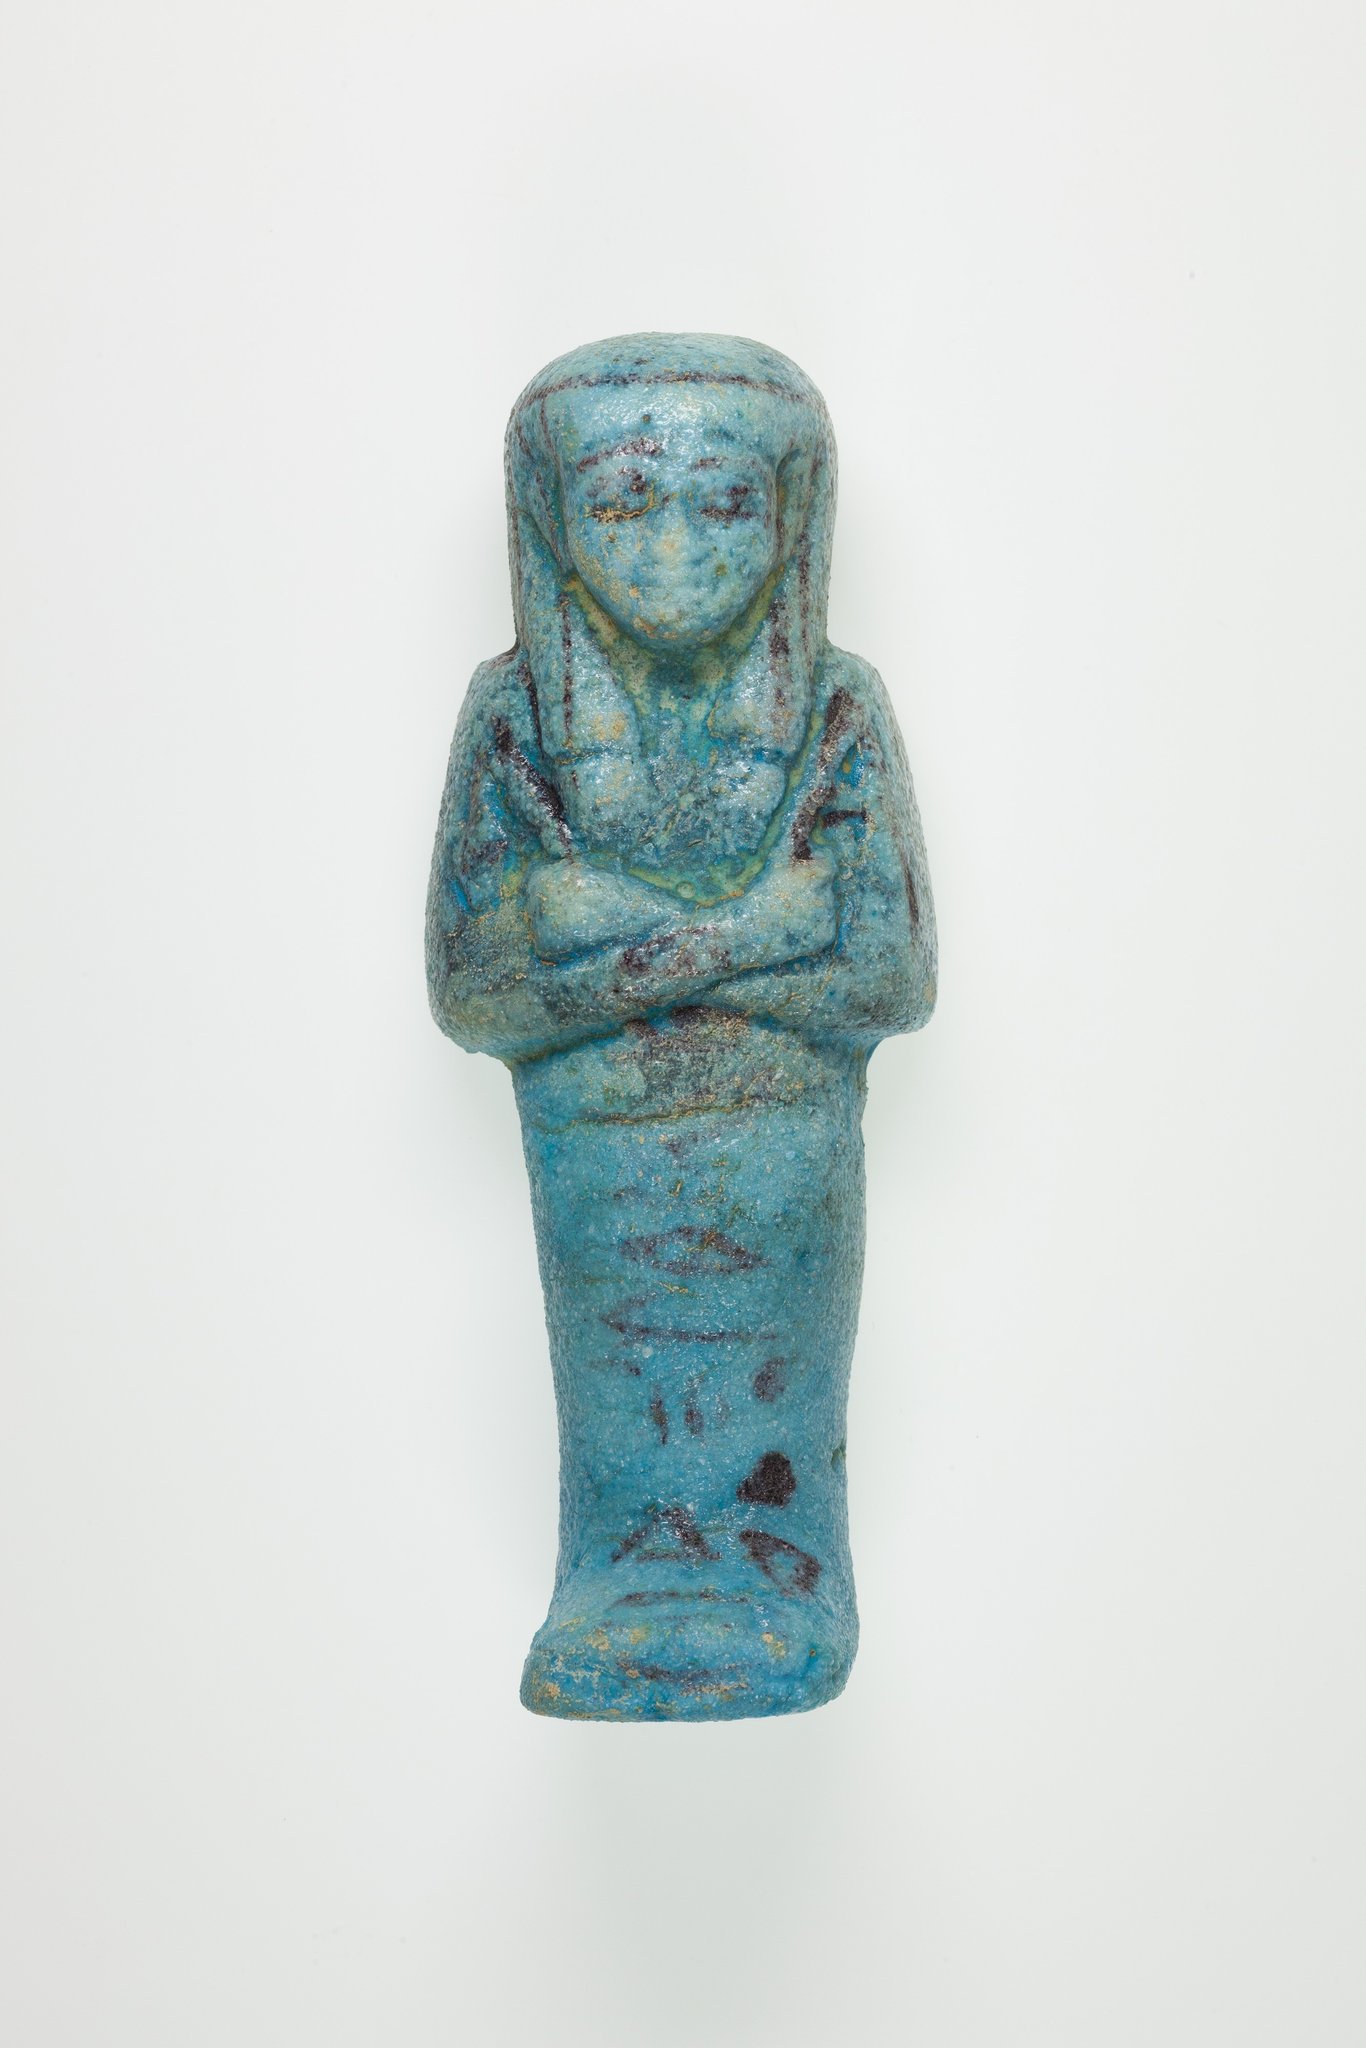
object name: shabti, henettawy c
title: Worker Shabti of Henettawy (C), Daughter of Isetemkheb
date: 990-970 BCE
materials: faience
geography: egypt